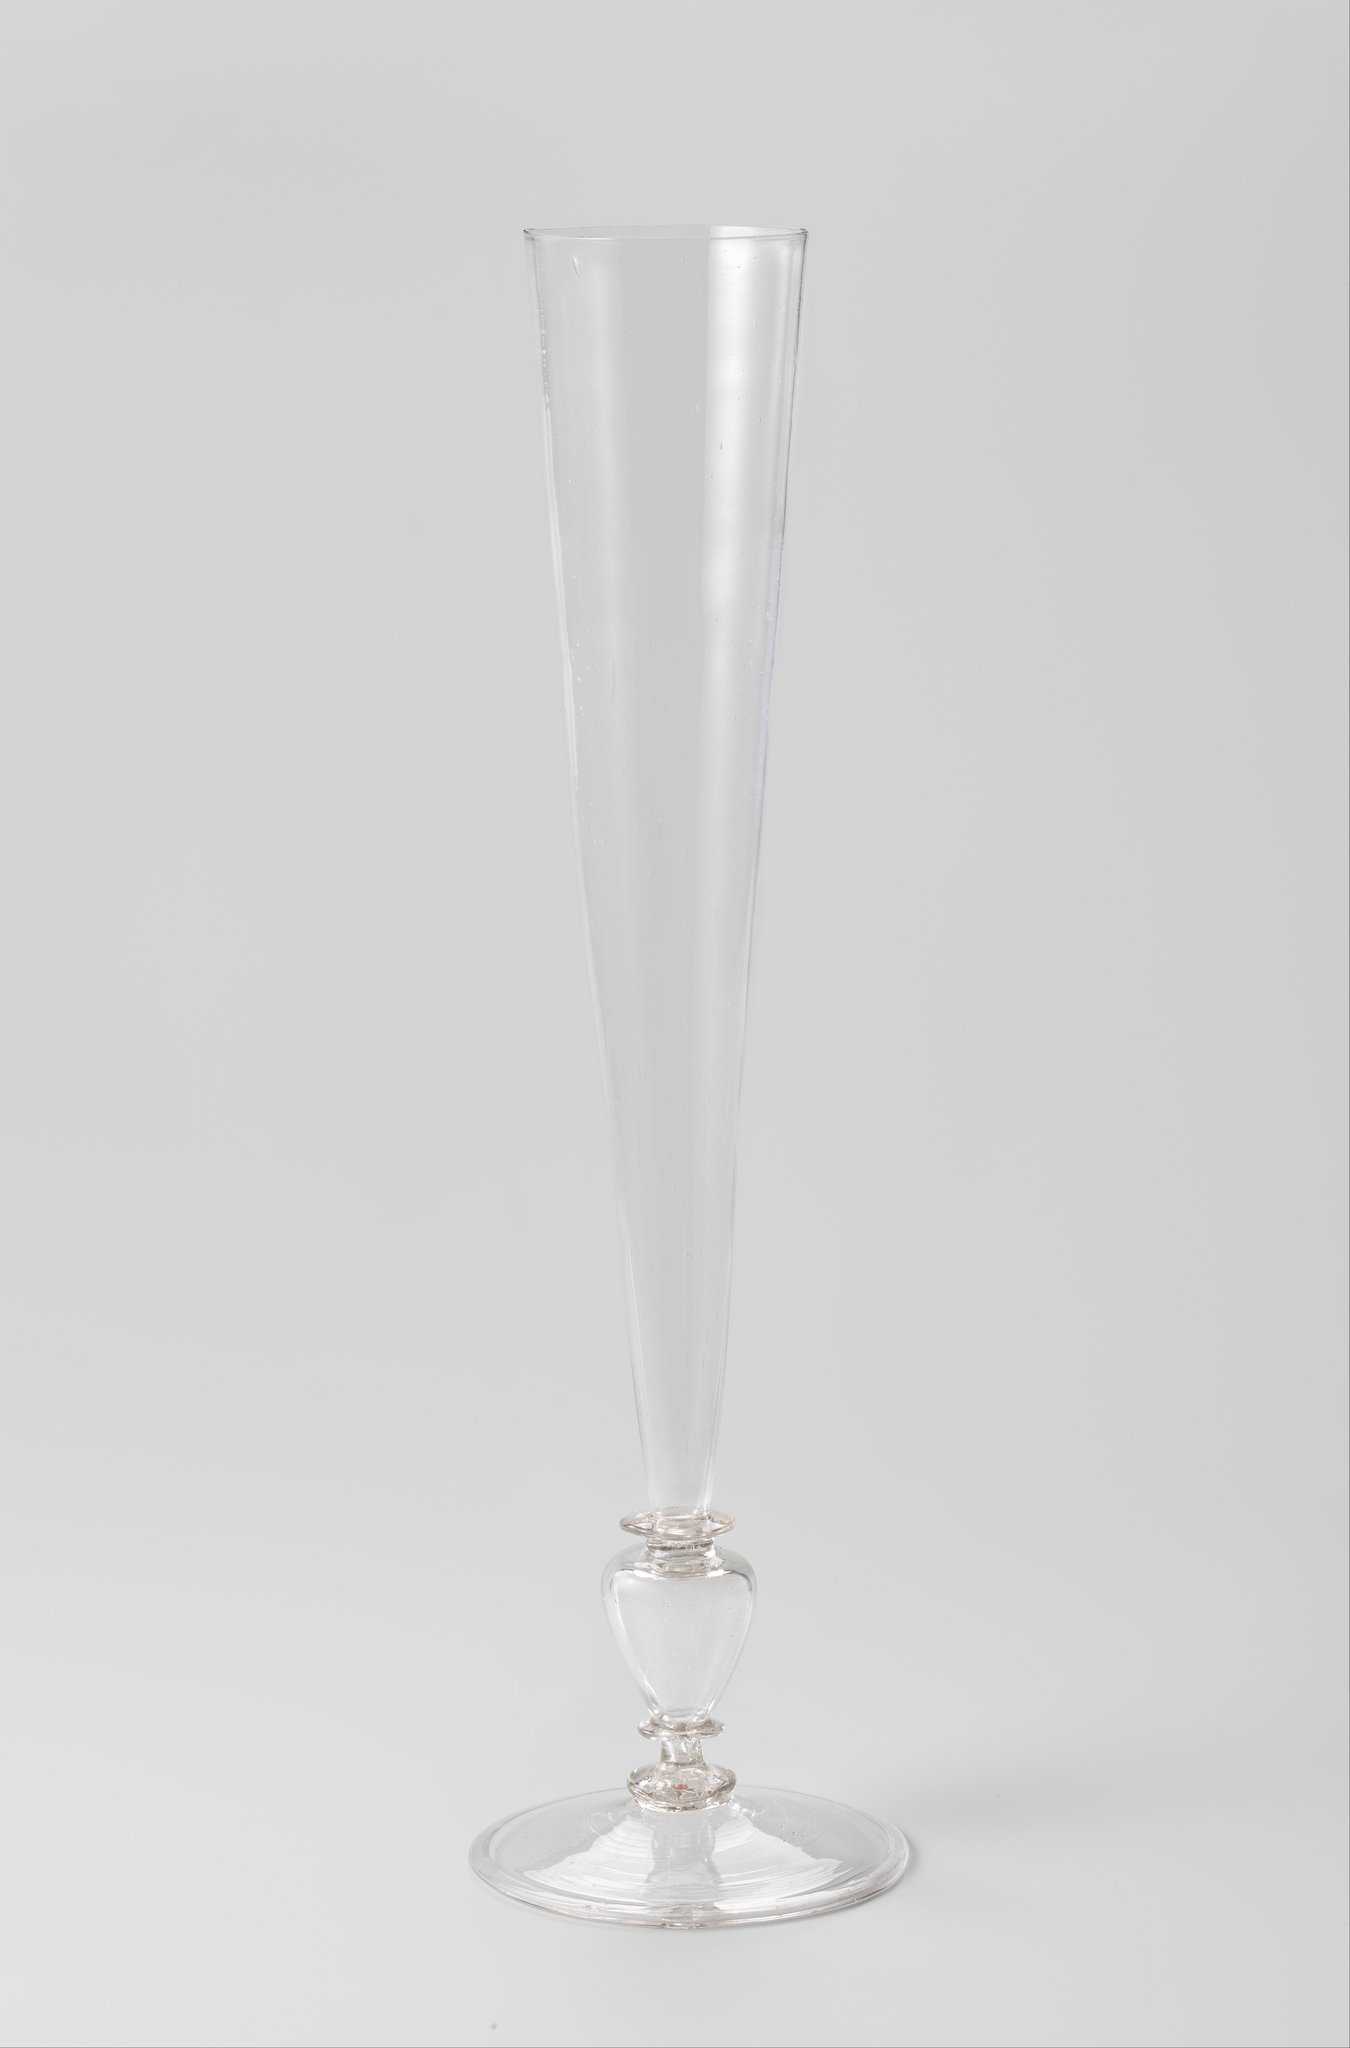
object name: flute glass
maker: Anonymous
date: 1600-1700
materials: glass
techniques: façon de venise, glassblowing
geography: netherlands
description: Platte voet met omgeslagen rand. De stam opgebouwd uit een holle baluster en een schijf. Hoge conische kelk.